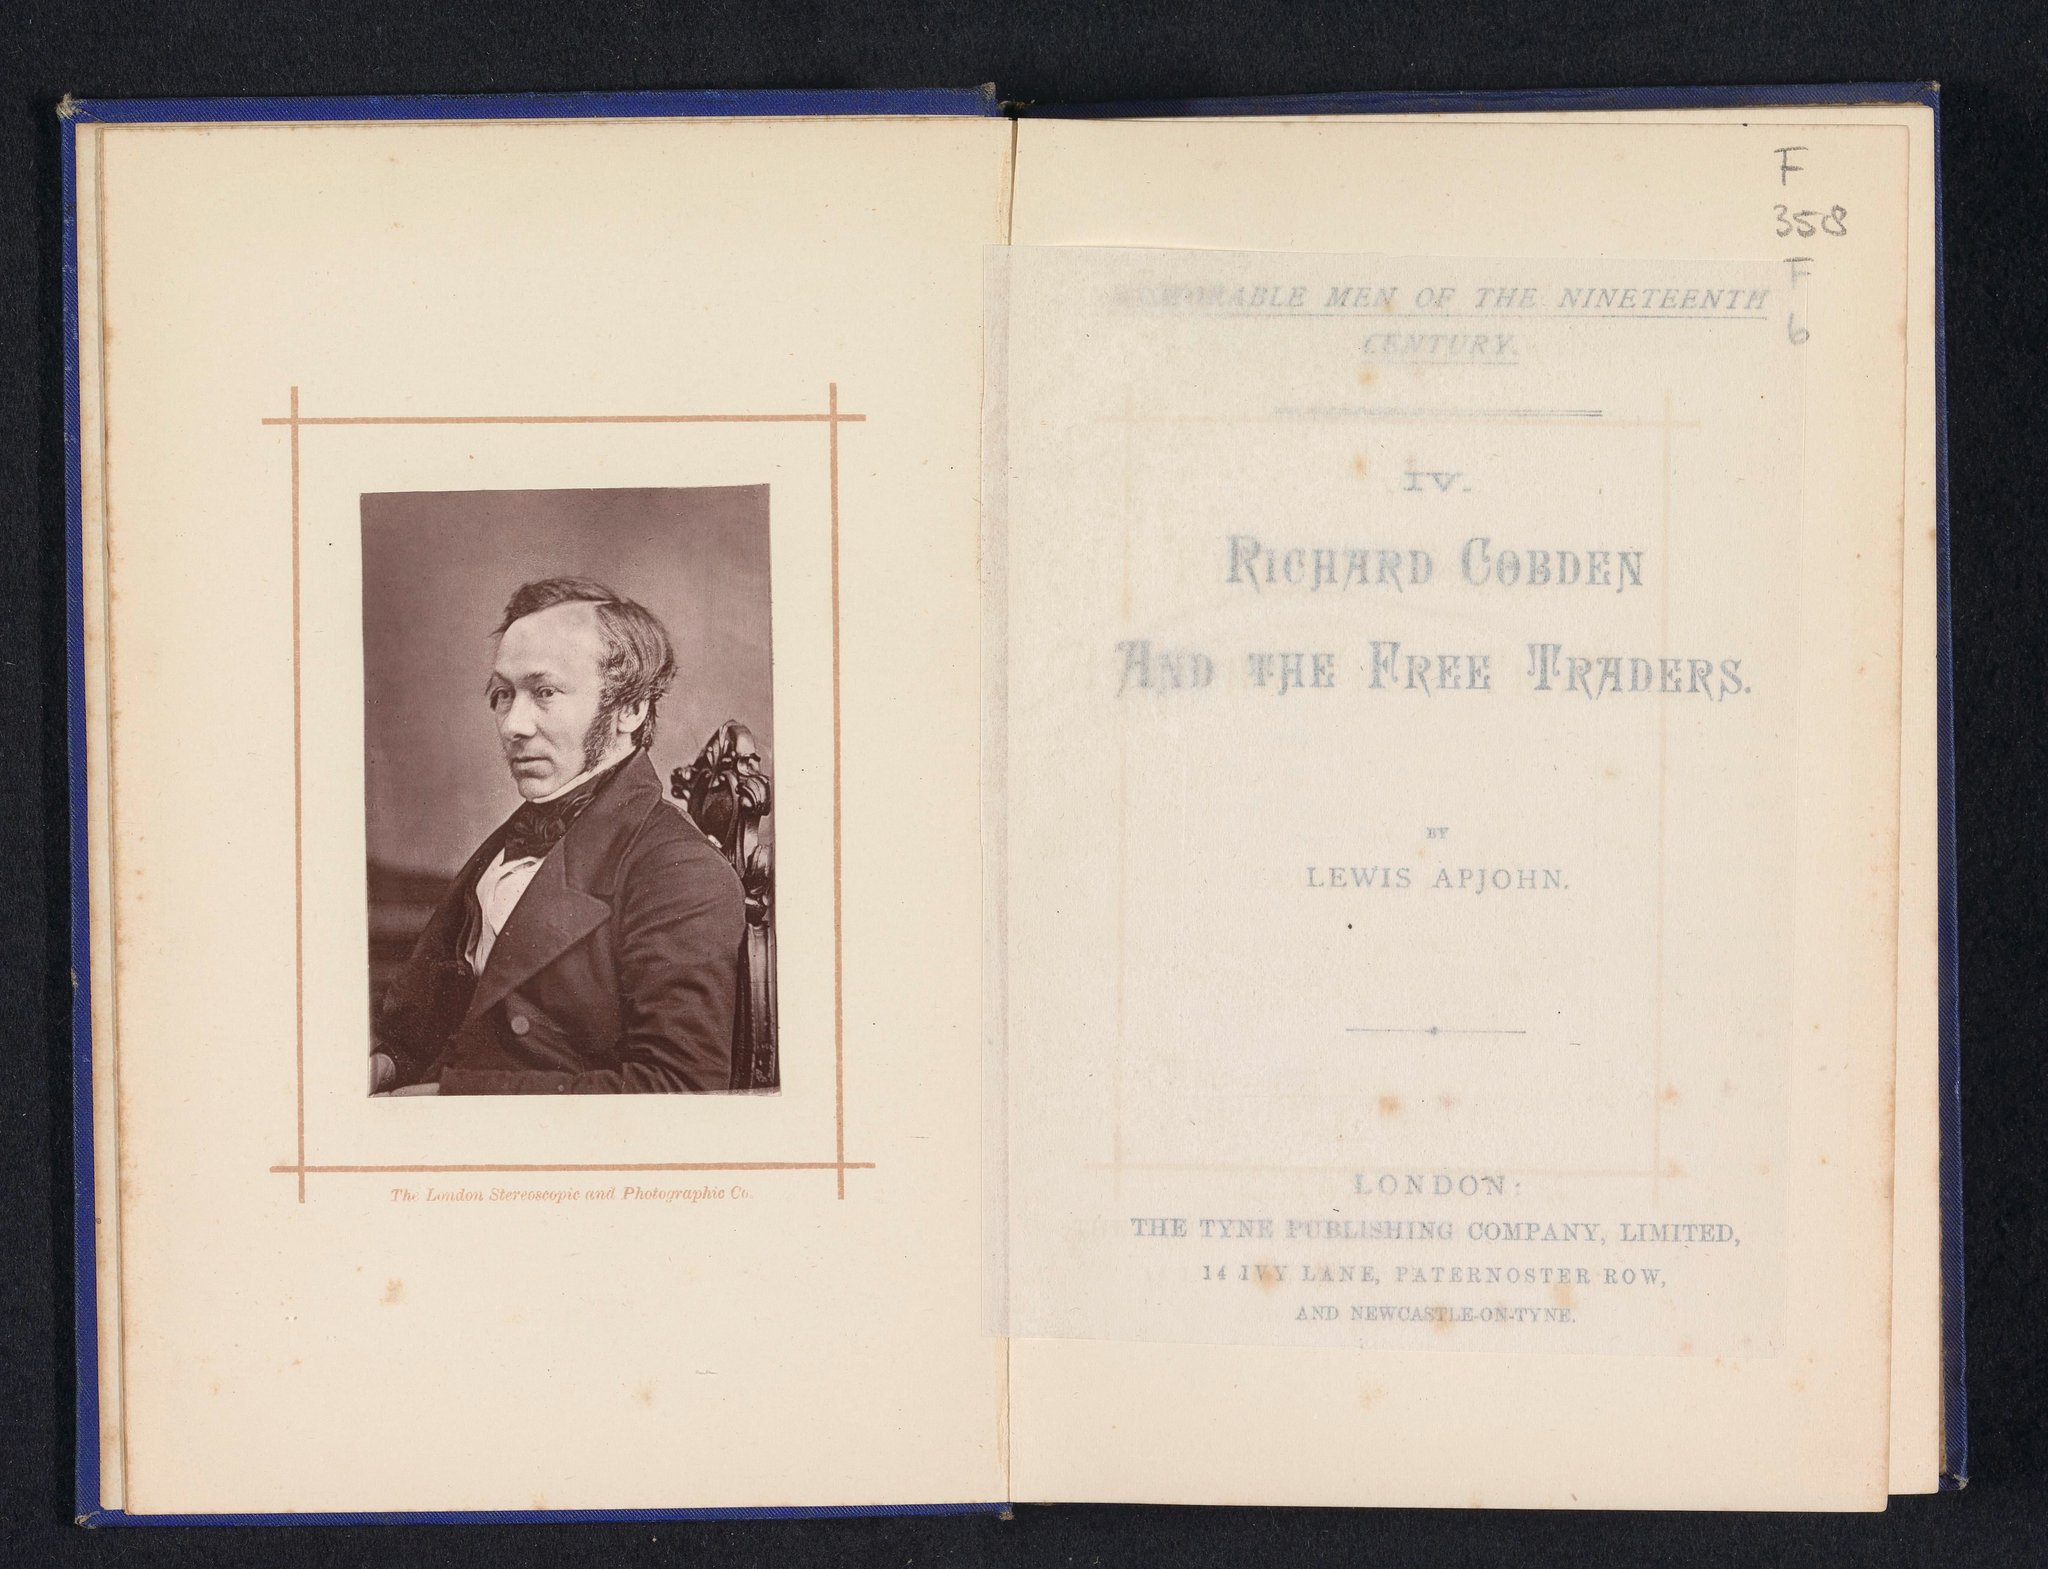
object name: photomechanical print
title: Portret van Richard Cobden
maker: Anonymous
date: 1855-1865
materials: paper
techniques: woodburytype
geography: london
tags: adult man, politician, e.g. party leader